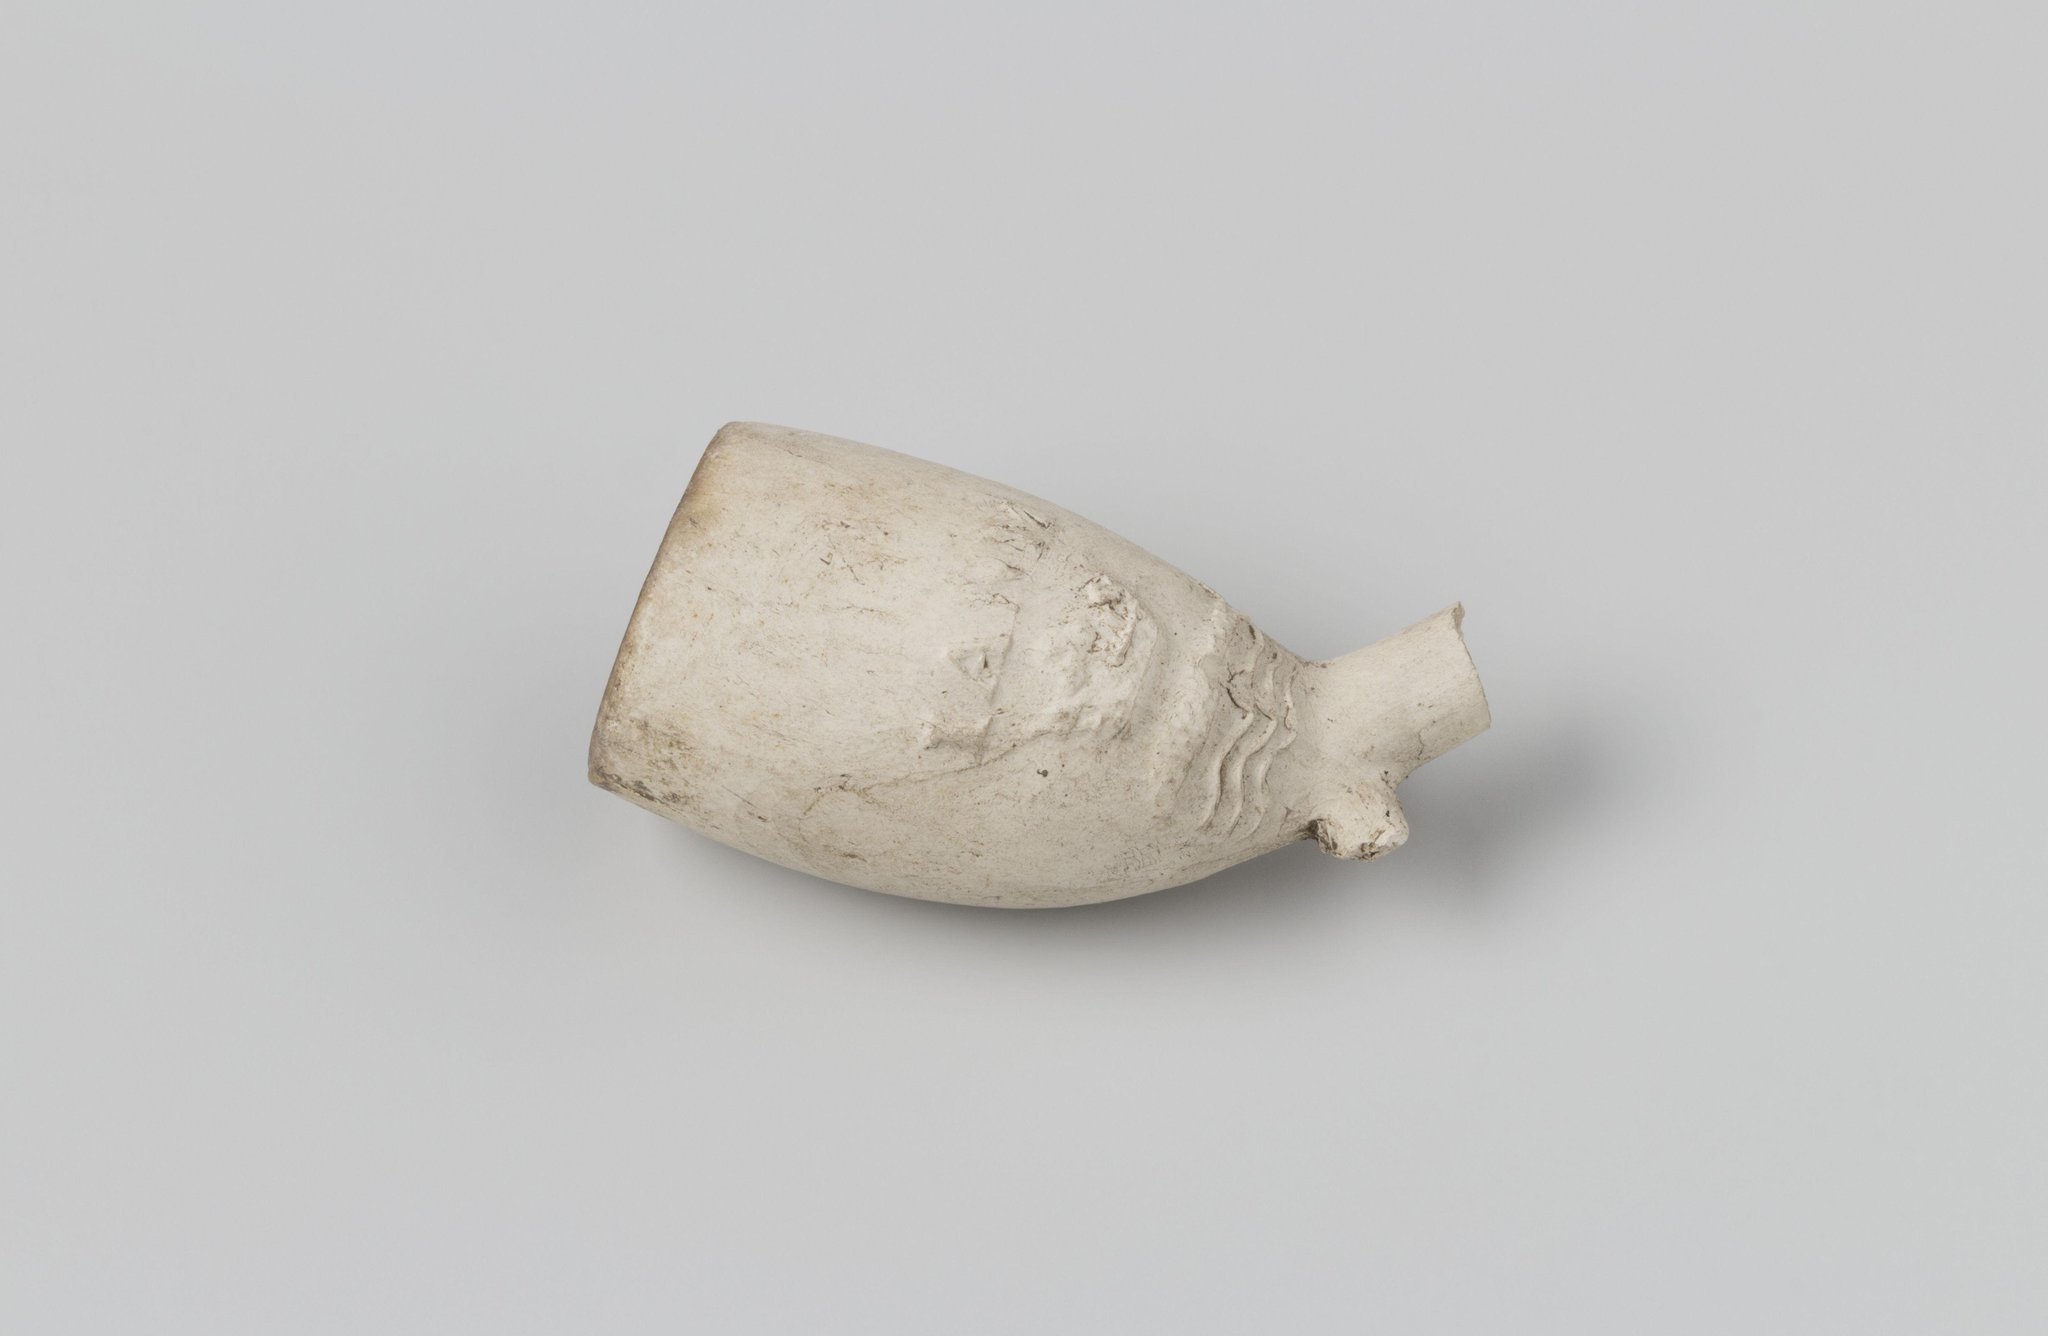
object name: fragment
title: Pijpenkop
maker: johannes willemsz. murk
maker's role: pijpenfabrikant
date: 1750-1795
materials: clay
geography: schoonhoven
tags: the hague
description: Pijpenkop met een kroon en de letters I A N M afgebeeld. Van de opgravingen op de Hofstede Arentsburg 1827-1831 onder toezicht van Professor Reuvens.